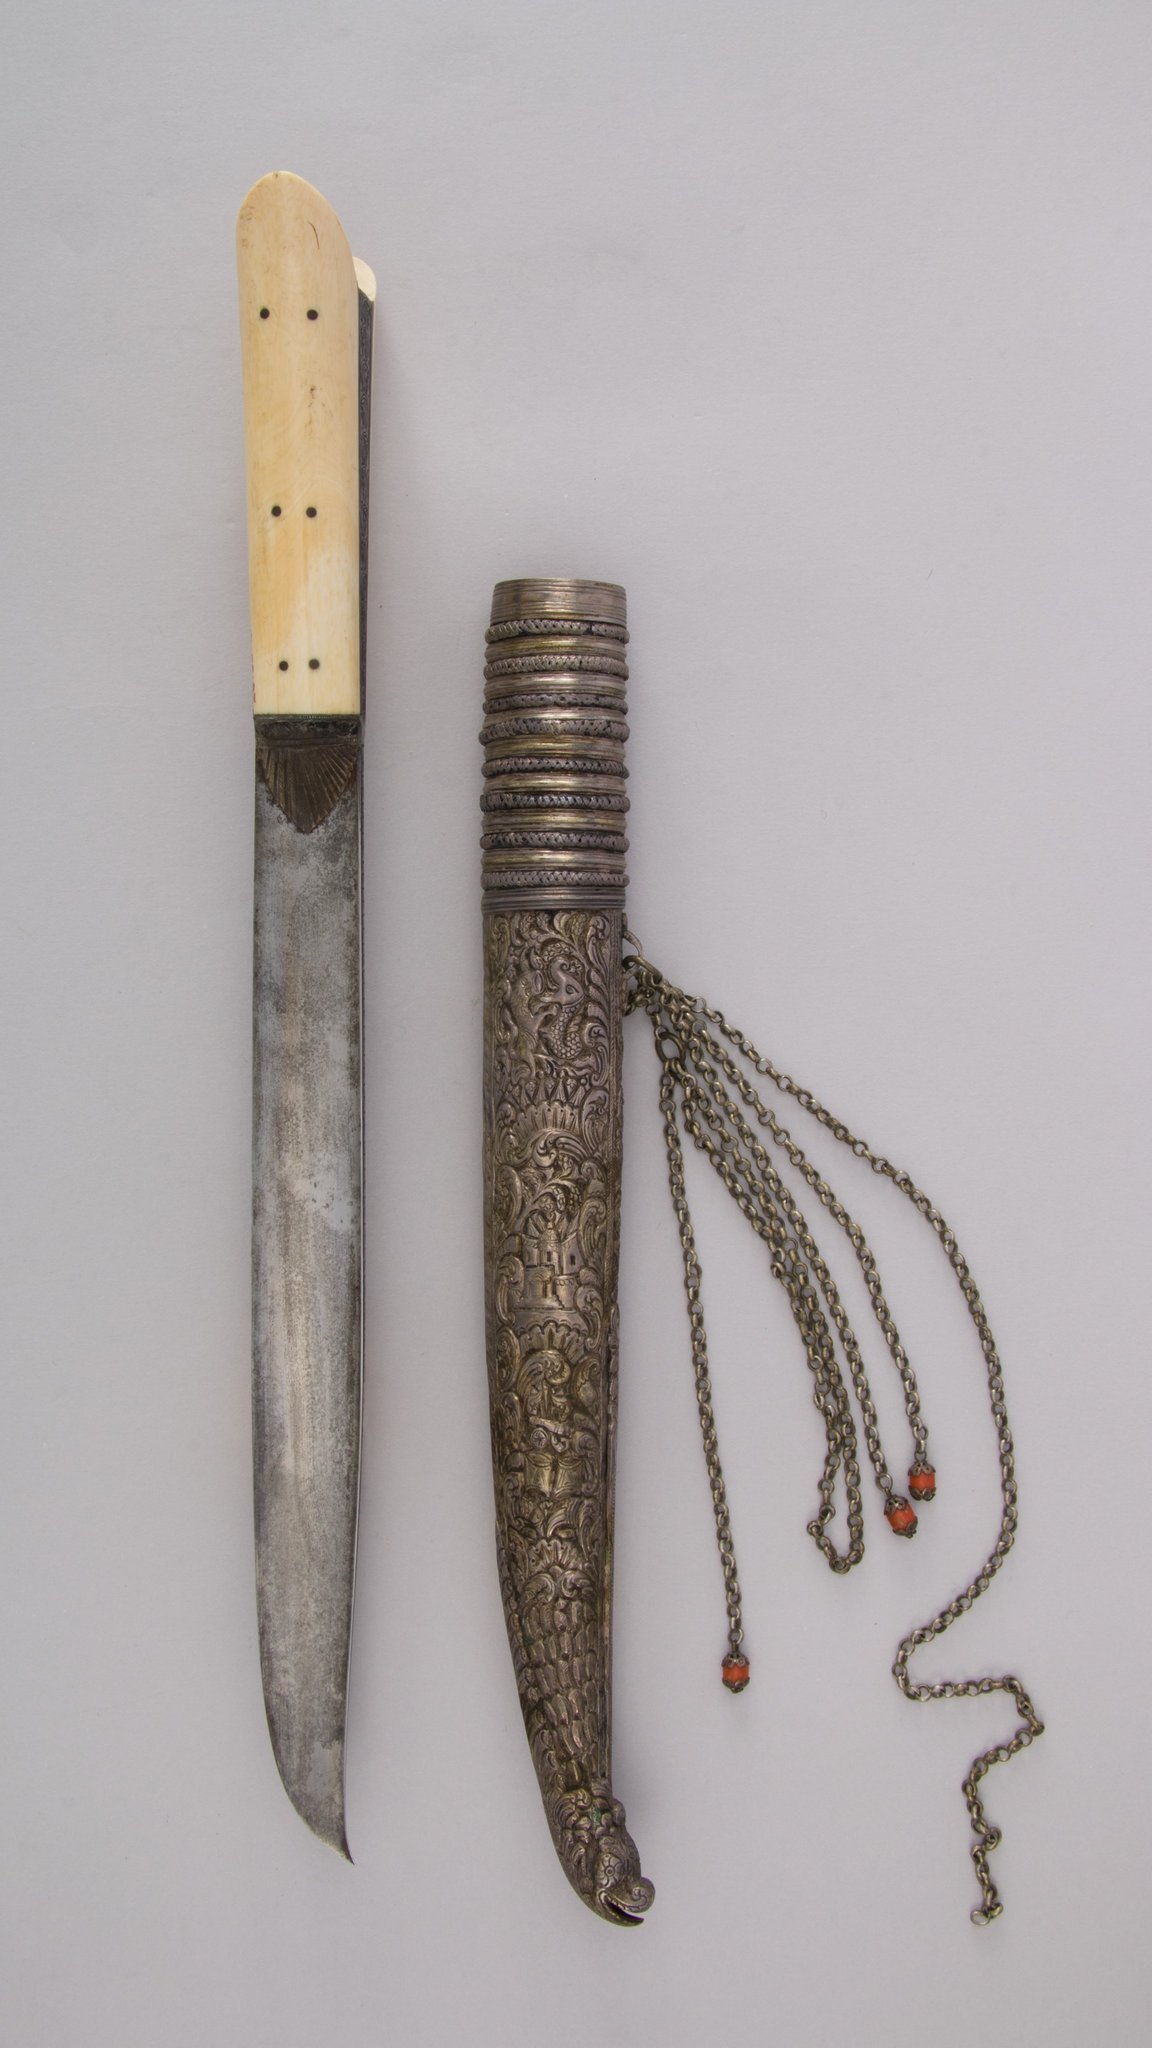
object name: dagger yatagan with sheath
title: Dagger (Yatagan) with Sheath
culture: balkan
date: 1701-1800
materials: gemstone, ivory, silver, steel